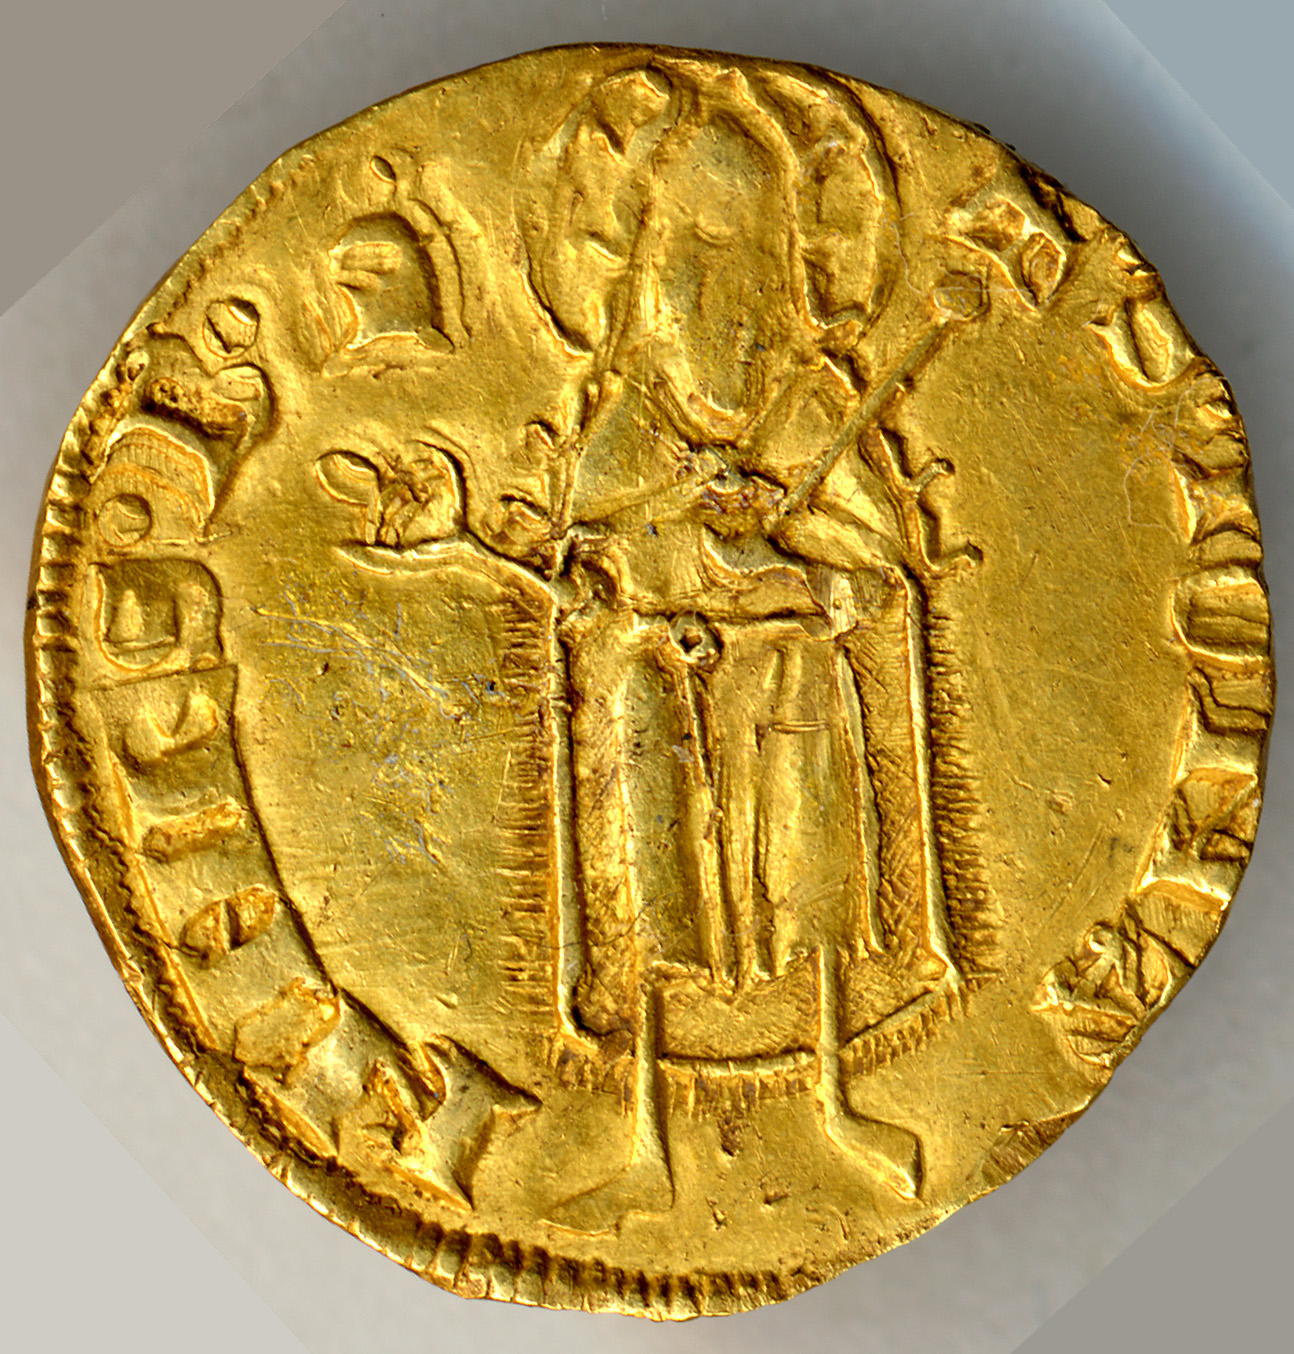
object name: coin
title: Florin d'or of John The Good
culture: french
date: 1301-1400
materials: gold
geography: france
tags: kings